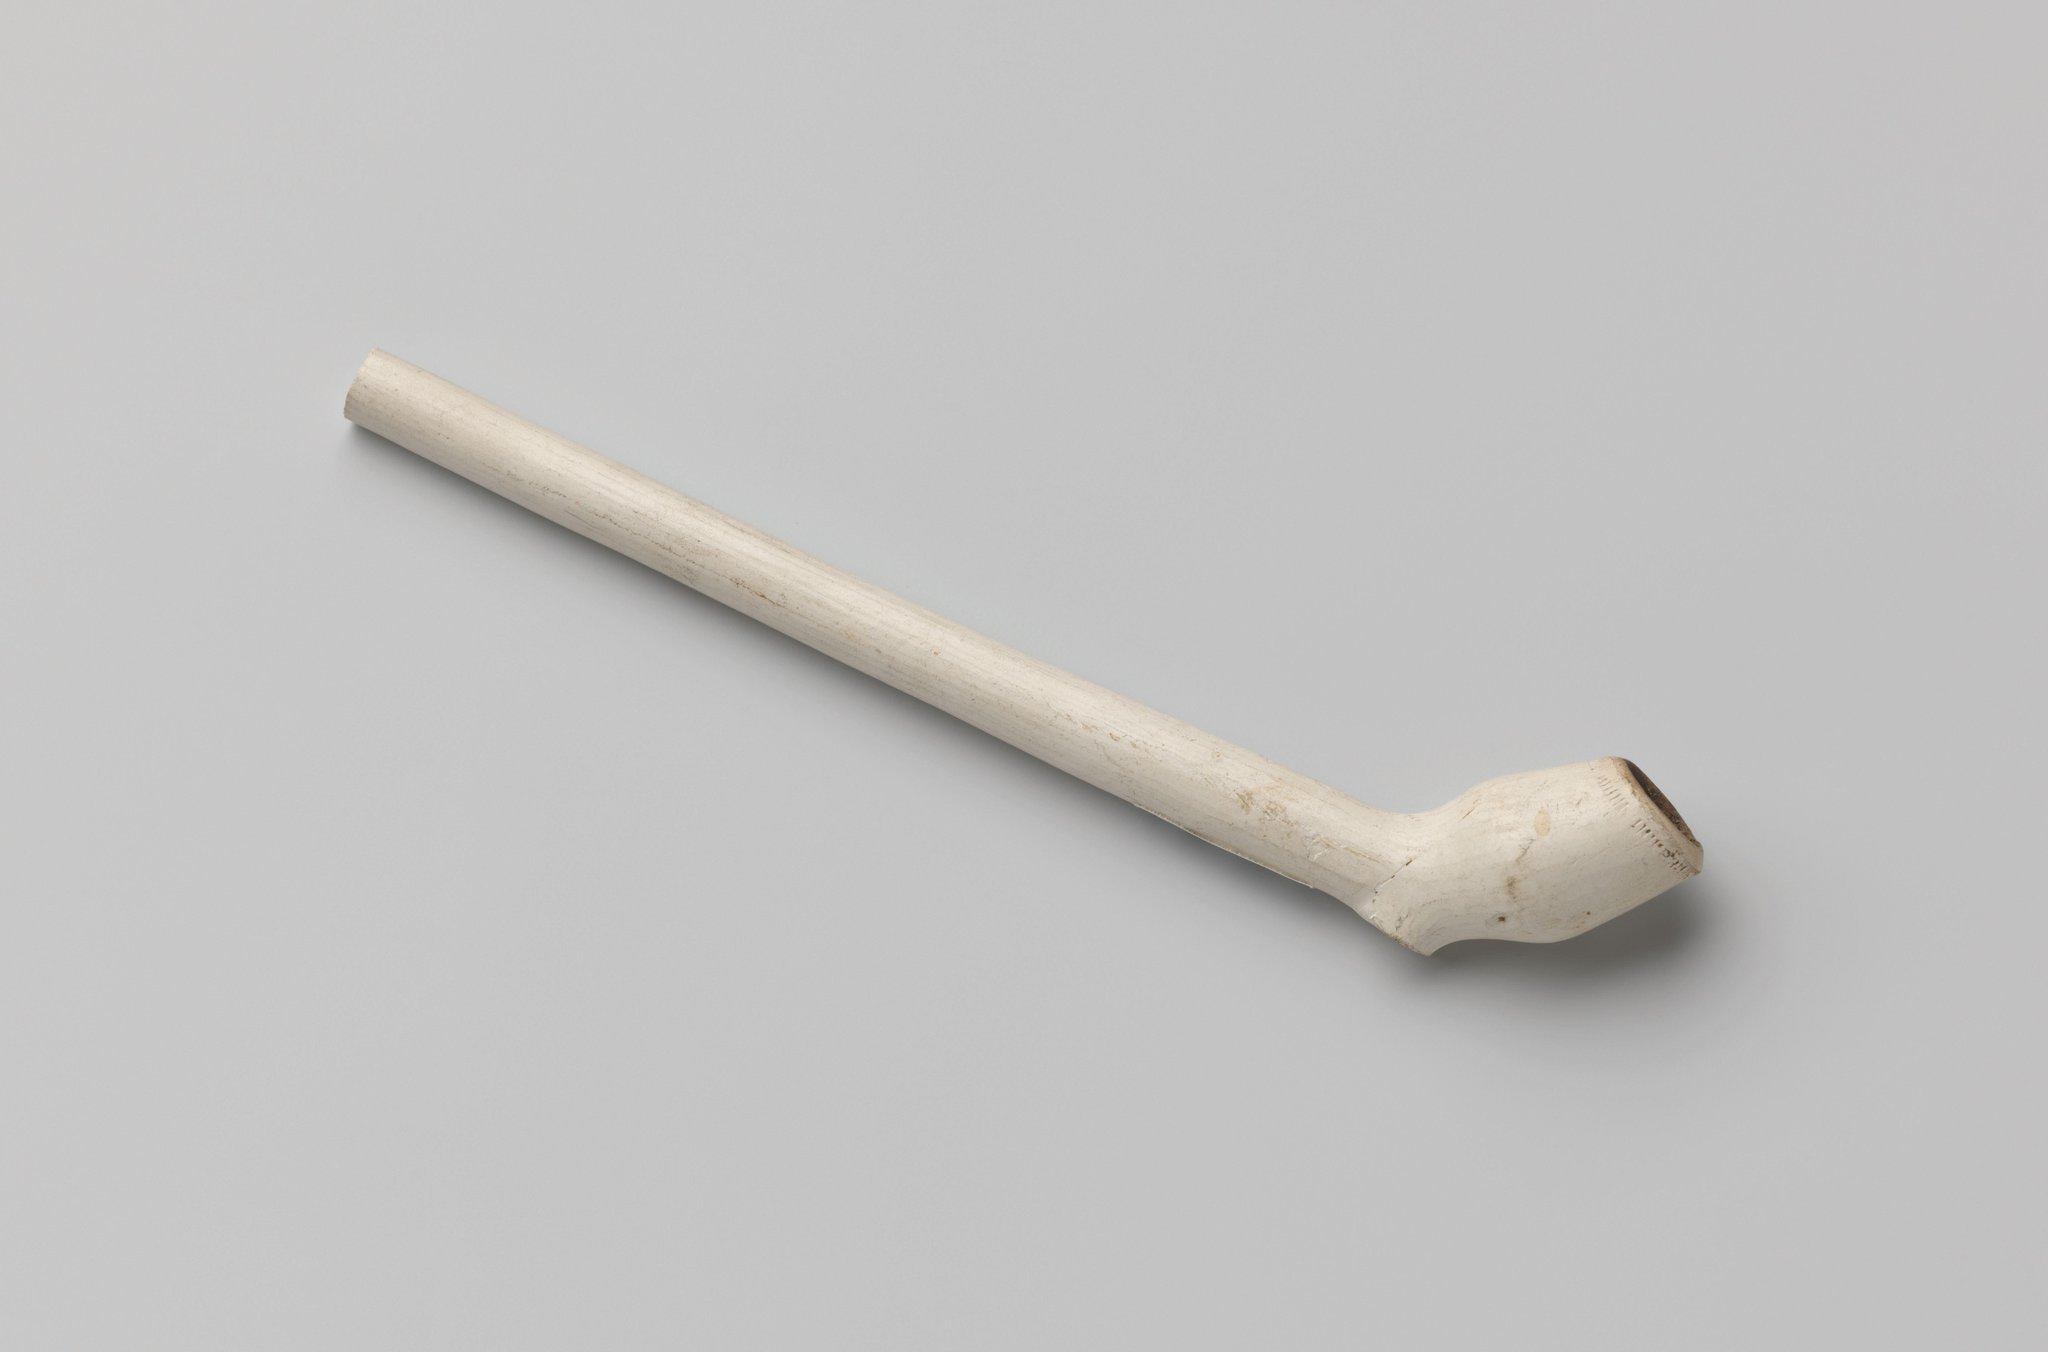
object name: tabakspijp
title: Gemerkte tabakspijp van pijpaarde, beschadigd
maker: Anonymous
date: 1500-1799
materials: clay